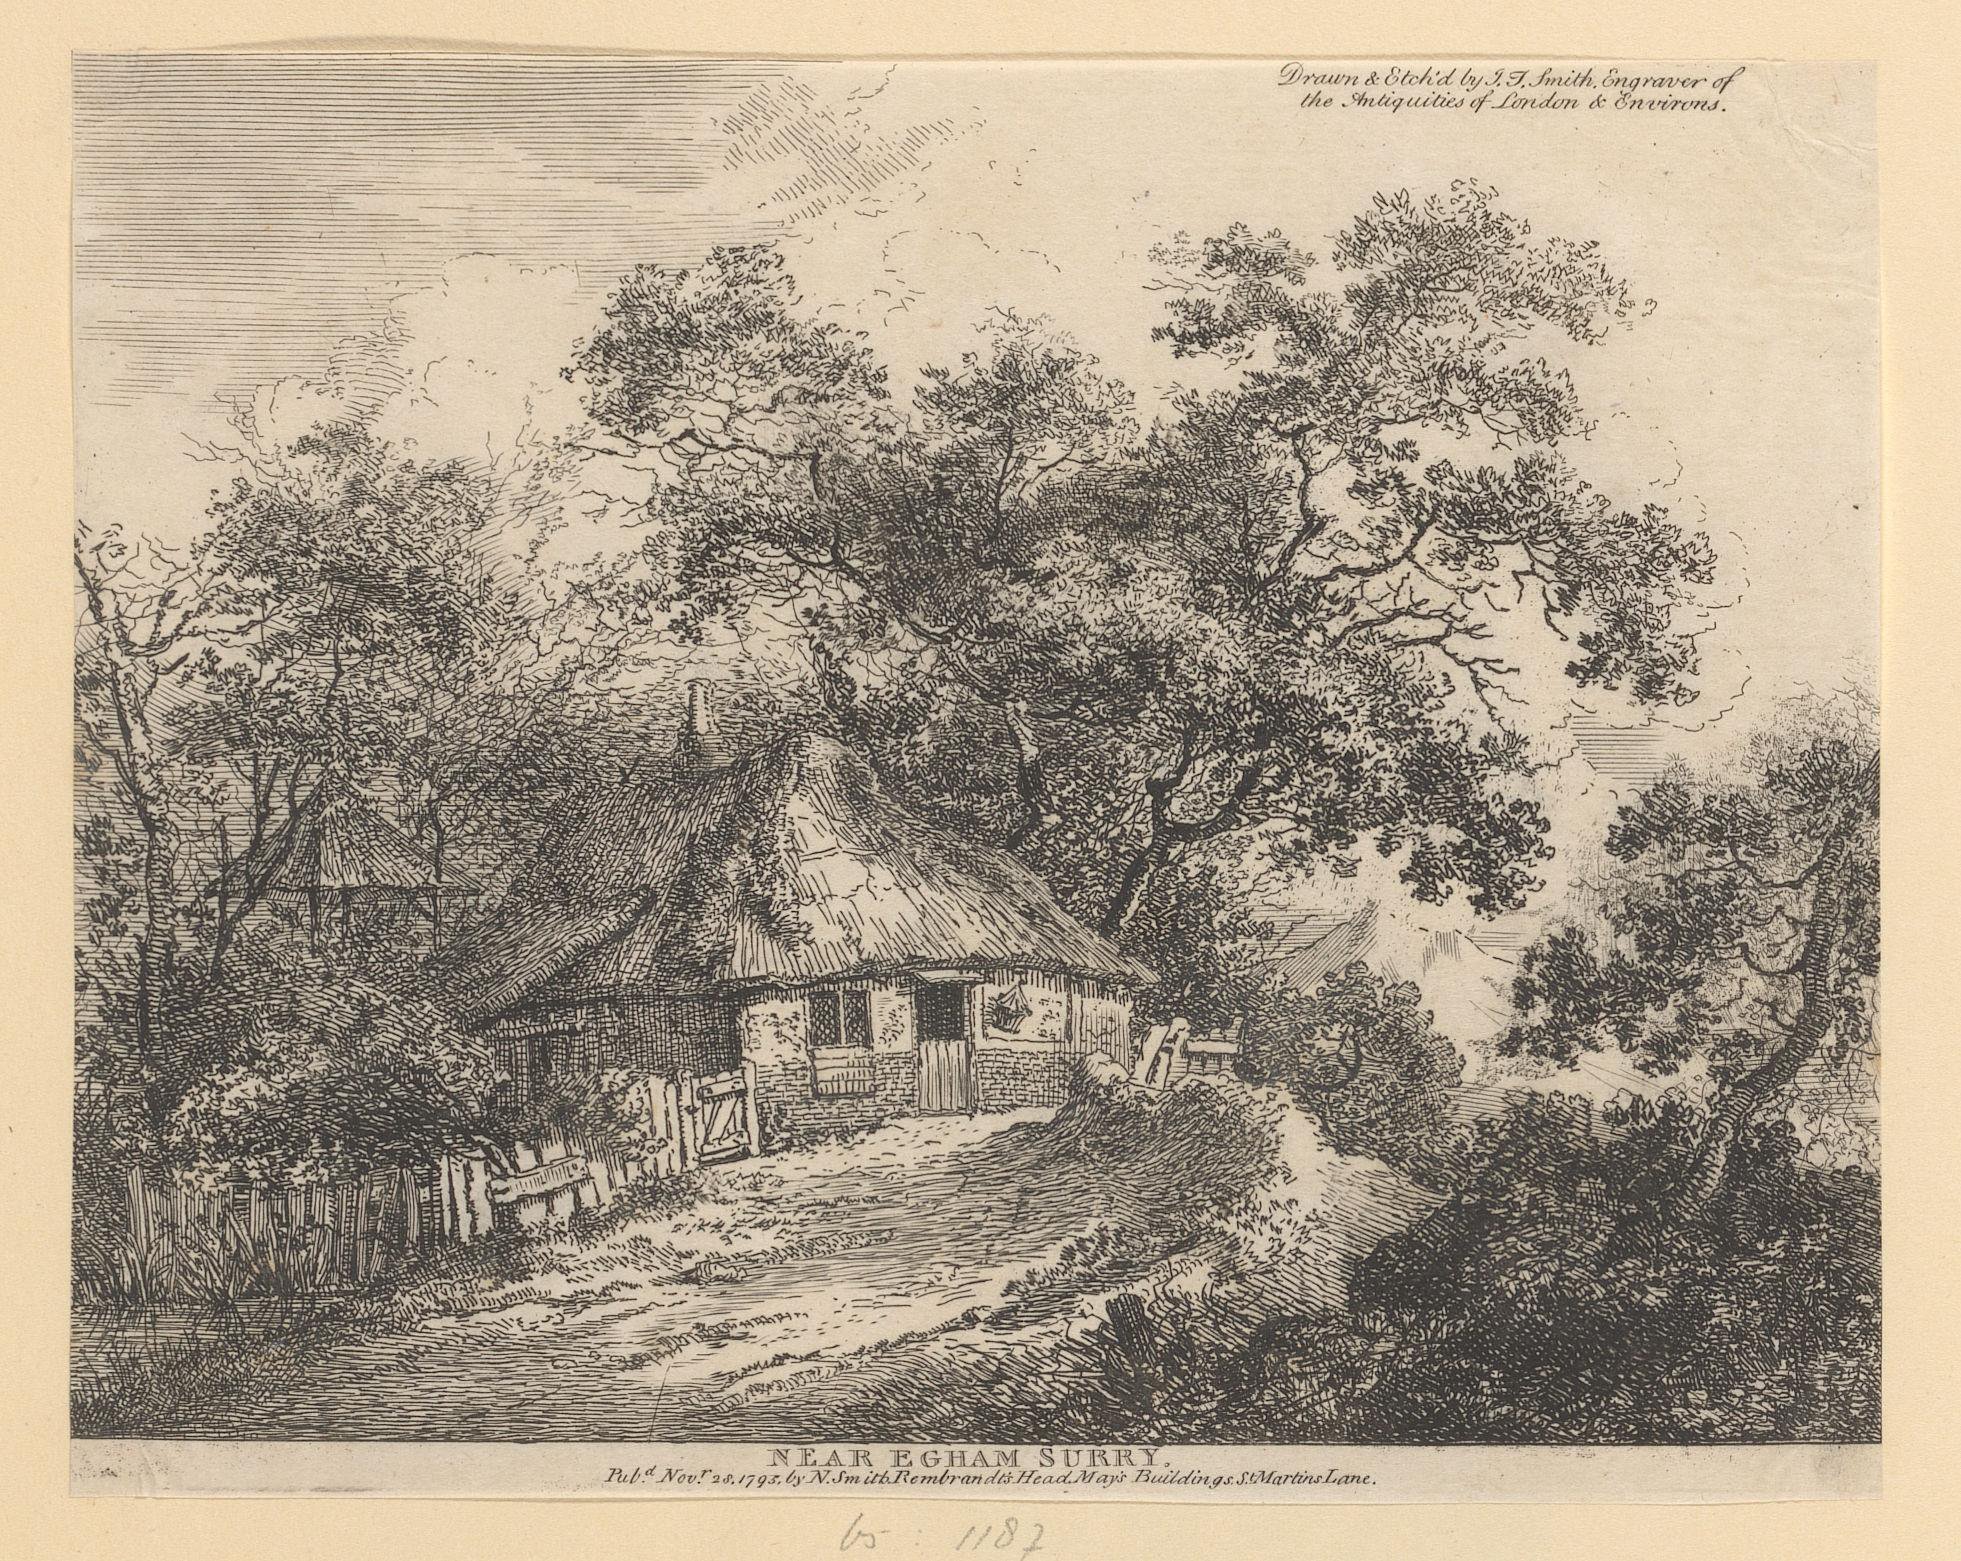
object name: print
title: Boerderij aan een landweg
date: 1793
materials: paper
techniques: etching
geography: london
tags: landscapes (+ landscape with figures, staffage), farm (building)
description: Deze prent hoort bij een serie van 20 prenten. Prent maakt mogelijk deel uit van een serie van 200 prenten. Deze serie is onder de titel 'A Collection of two hundred original etchings' voor het eerst uitgegeven door J.M. Greery in 1816.